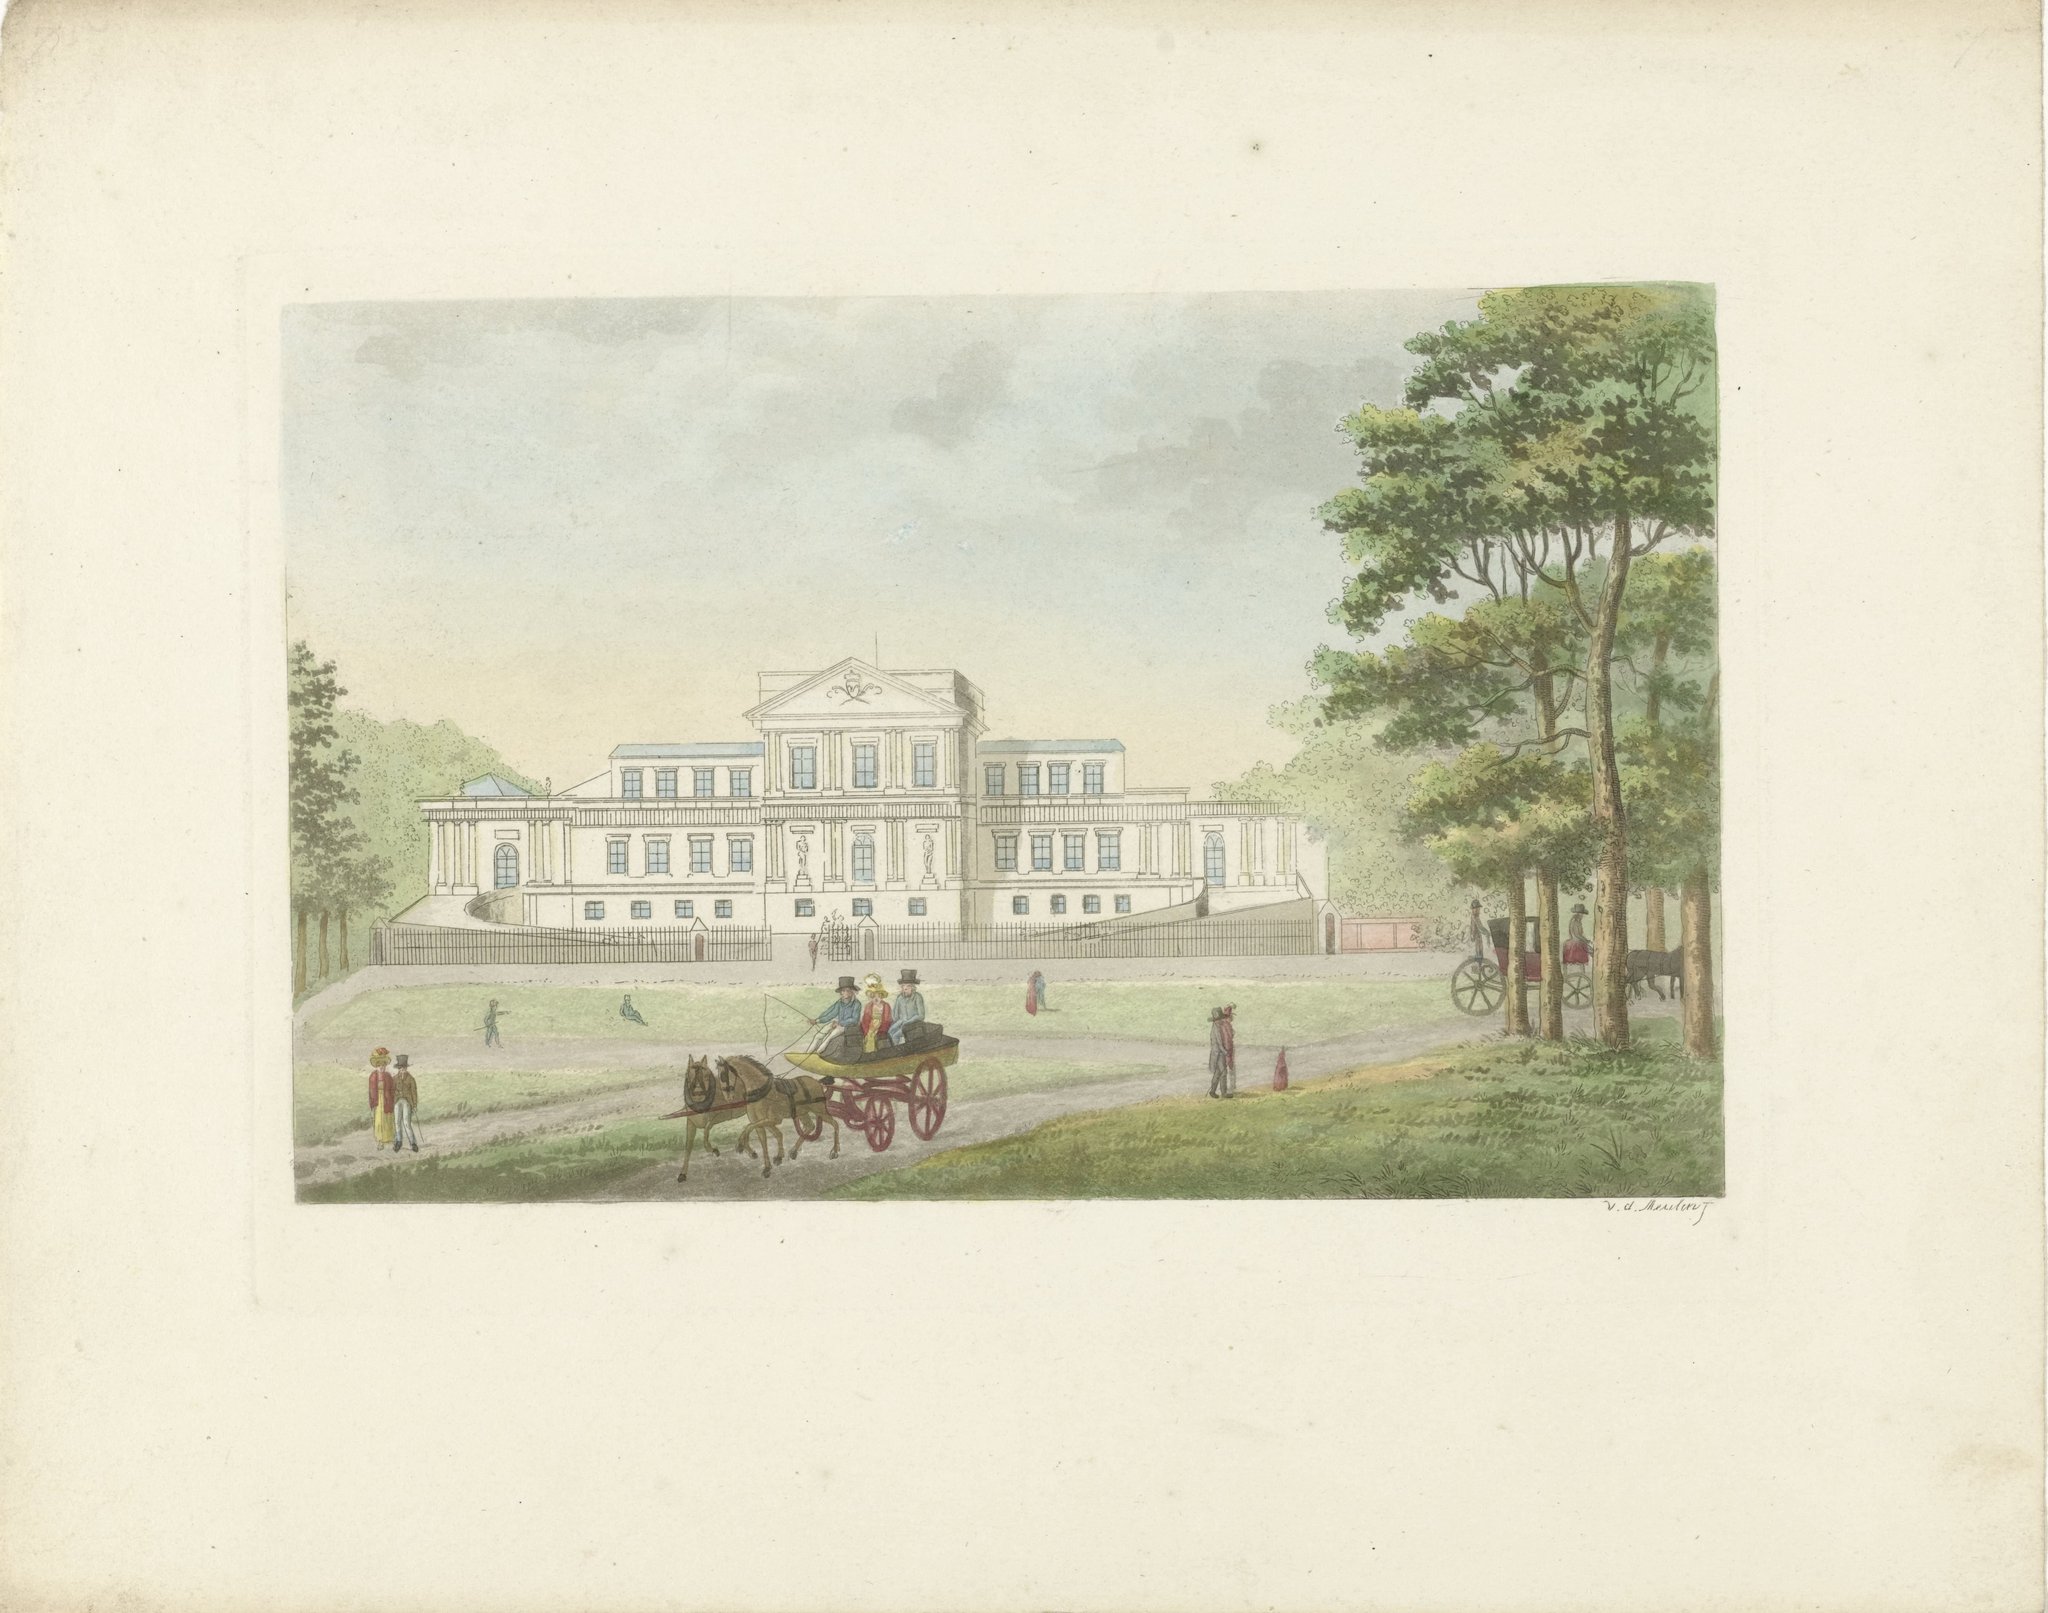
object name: print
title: Paviljoen Welgelegen te Haarlem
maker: roelof van der meulen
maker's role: draughtsman, print maker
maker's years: 1806-1833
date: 1816-1833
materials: paper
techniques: aquatint, etching, hand coloring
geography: amsterdam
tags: country-house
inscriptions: collector's mark: Lugt 2228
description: Prent gebruikt in een van de edities van: Maaskamp, Evert. Tableau des principales vues des palais et édifices : représentations et des coutumes et usages, dans les provinces septentrionales du Royaume des Pays-Bas. Amsterdam, Evert Maaskamp, 1824.